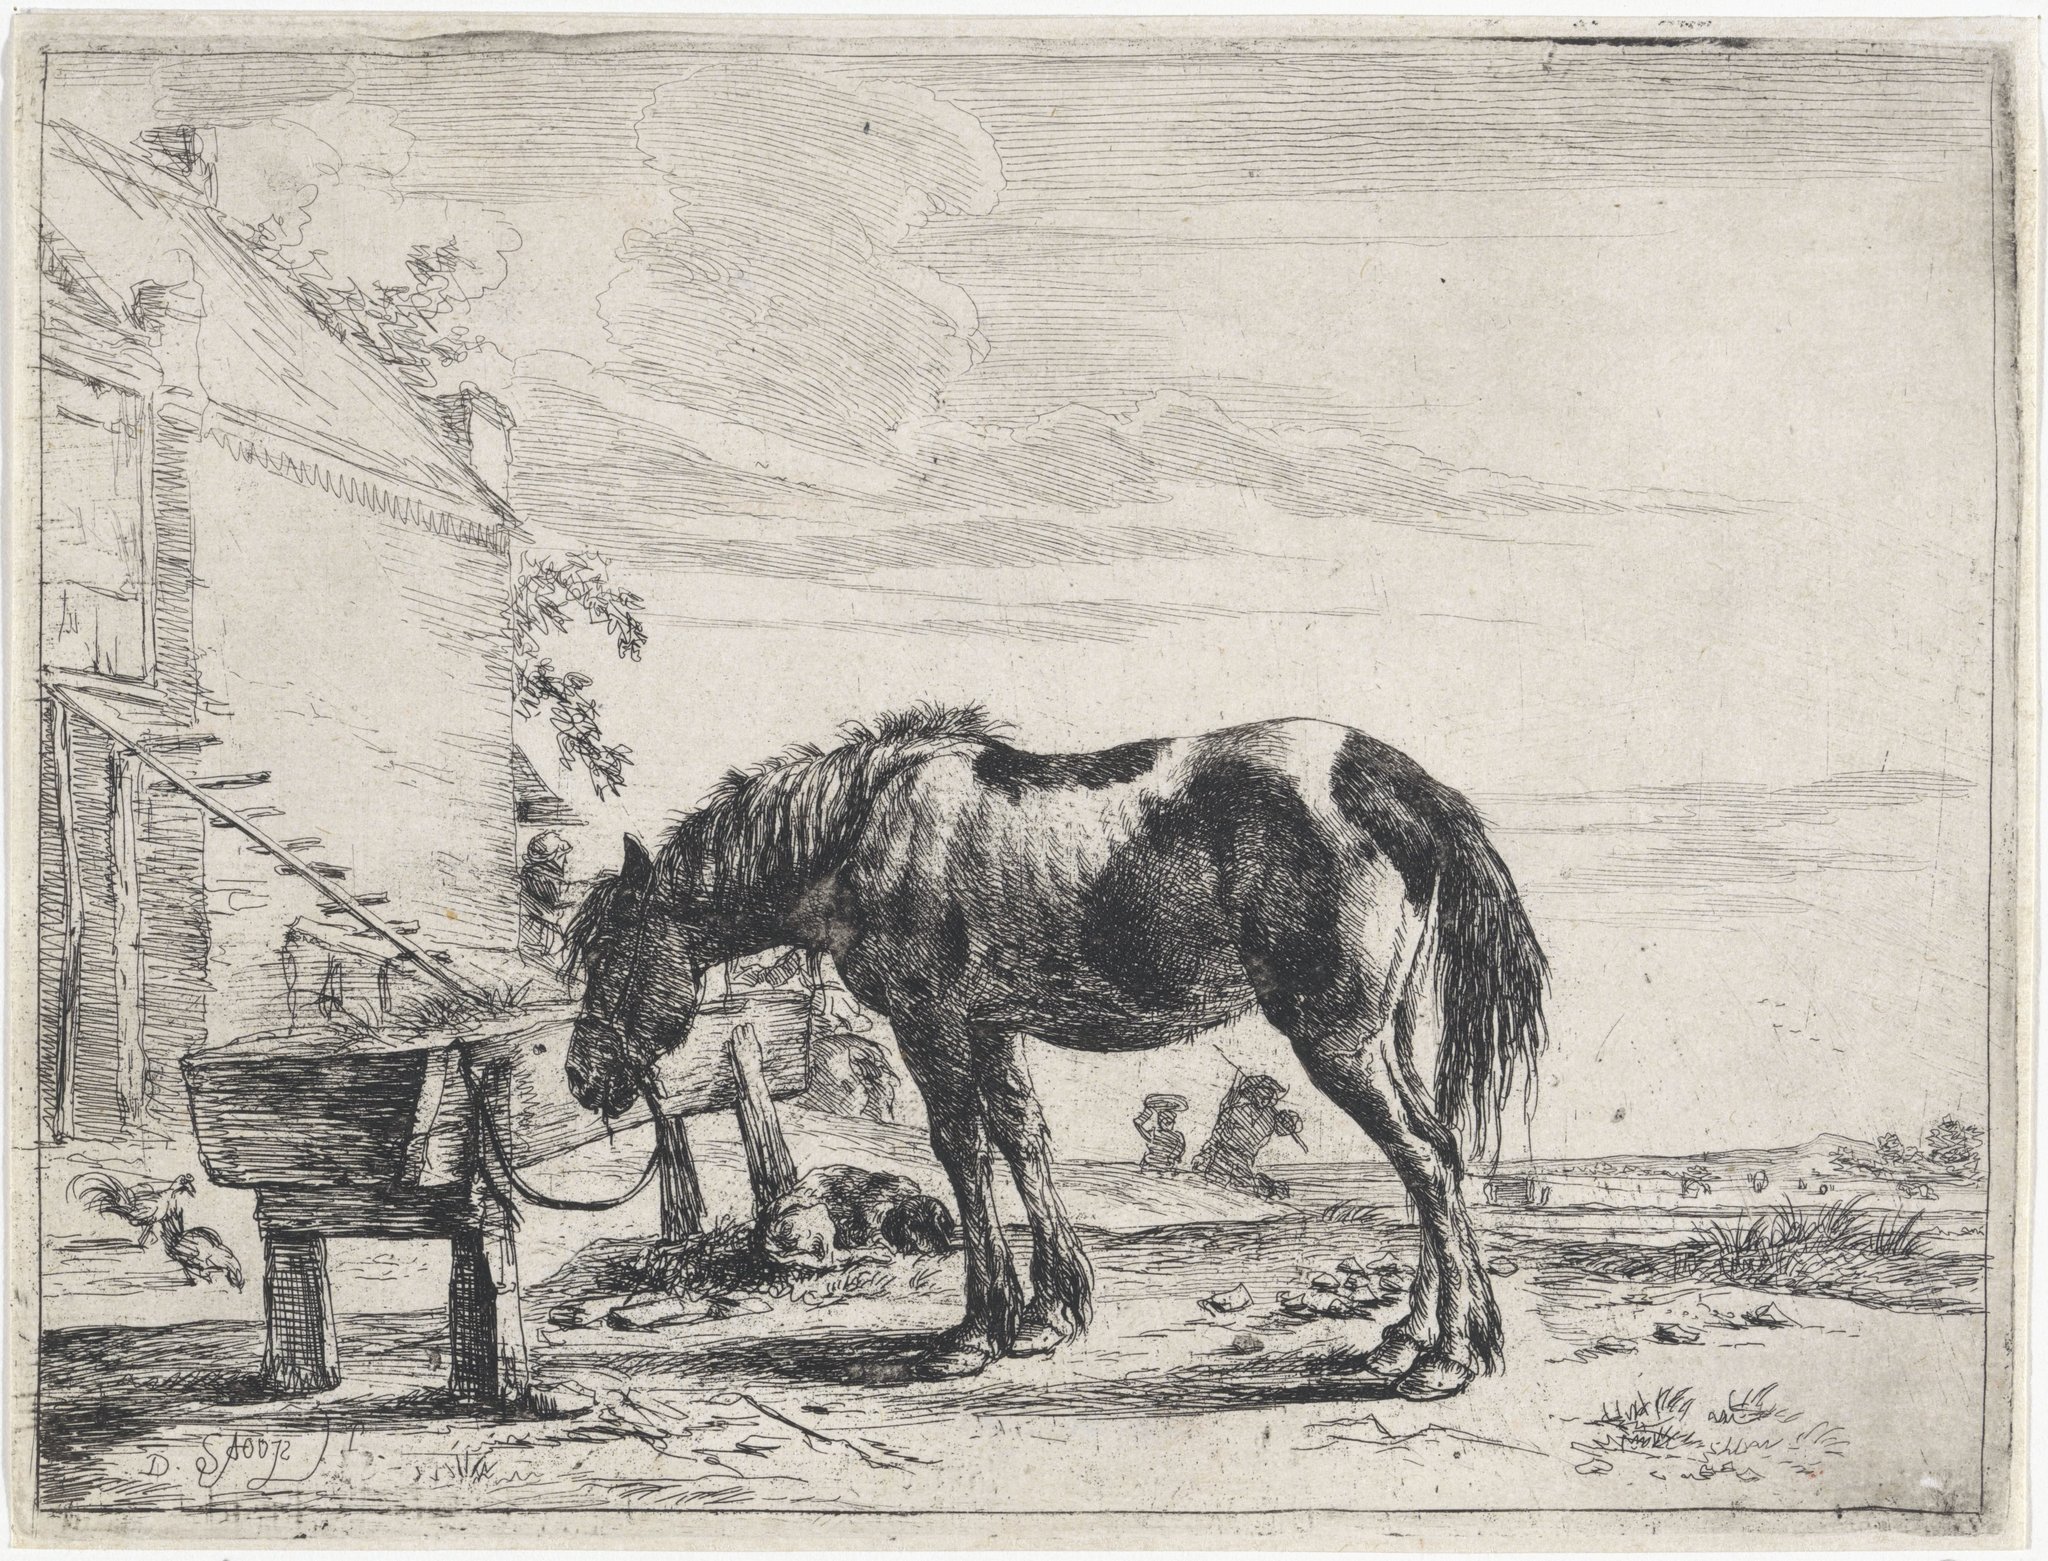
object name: print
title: Aan een voederbak vastgebonden paard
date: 1651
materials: paper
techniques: etching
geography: amsterdam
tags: horse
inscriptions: collector's mark: Lugt 240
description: Een paard staat vastgebonden aan een voederbak. Links een huis.